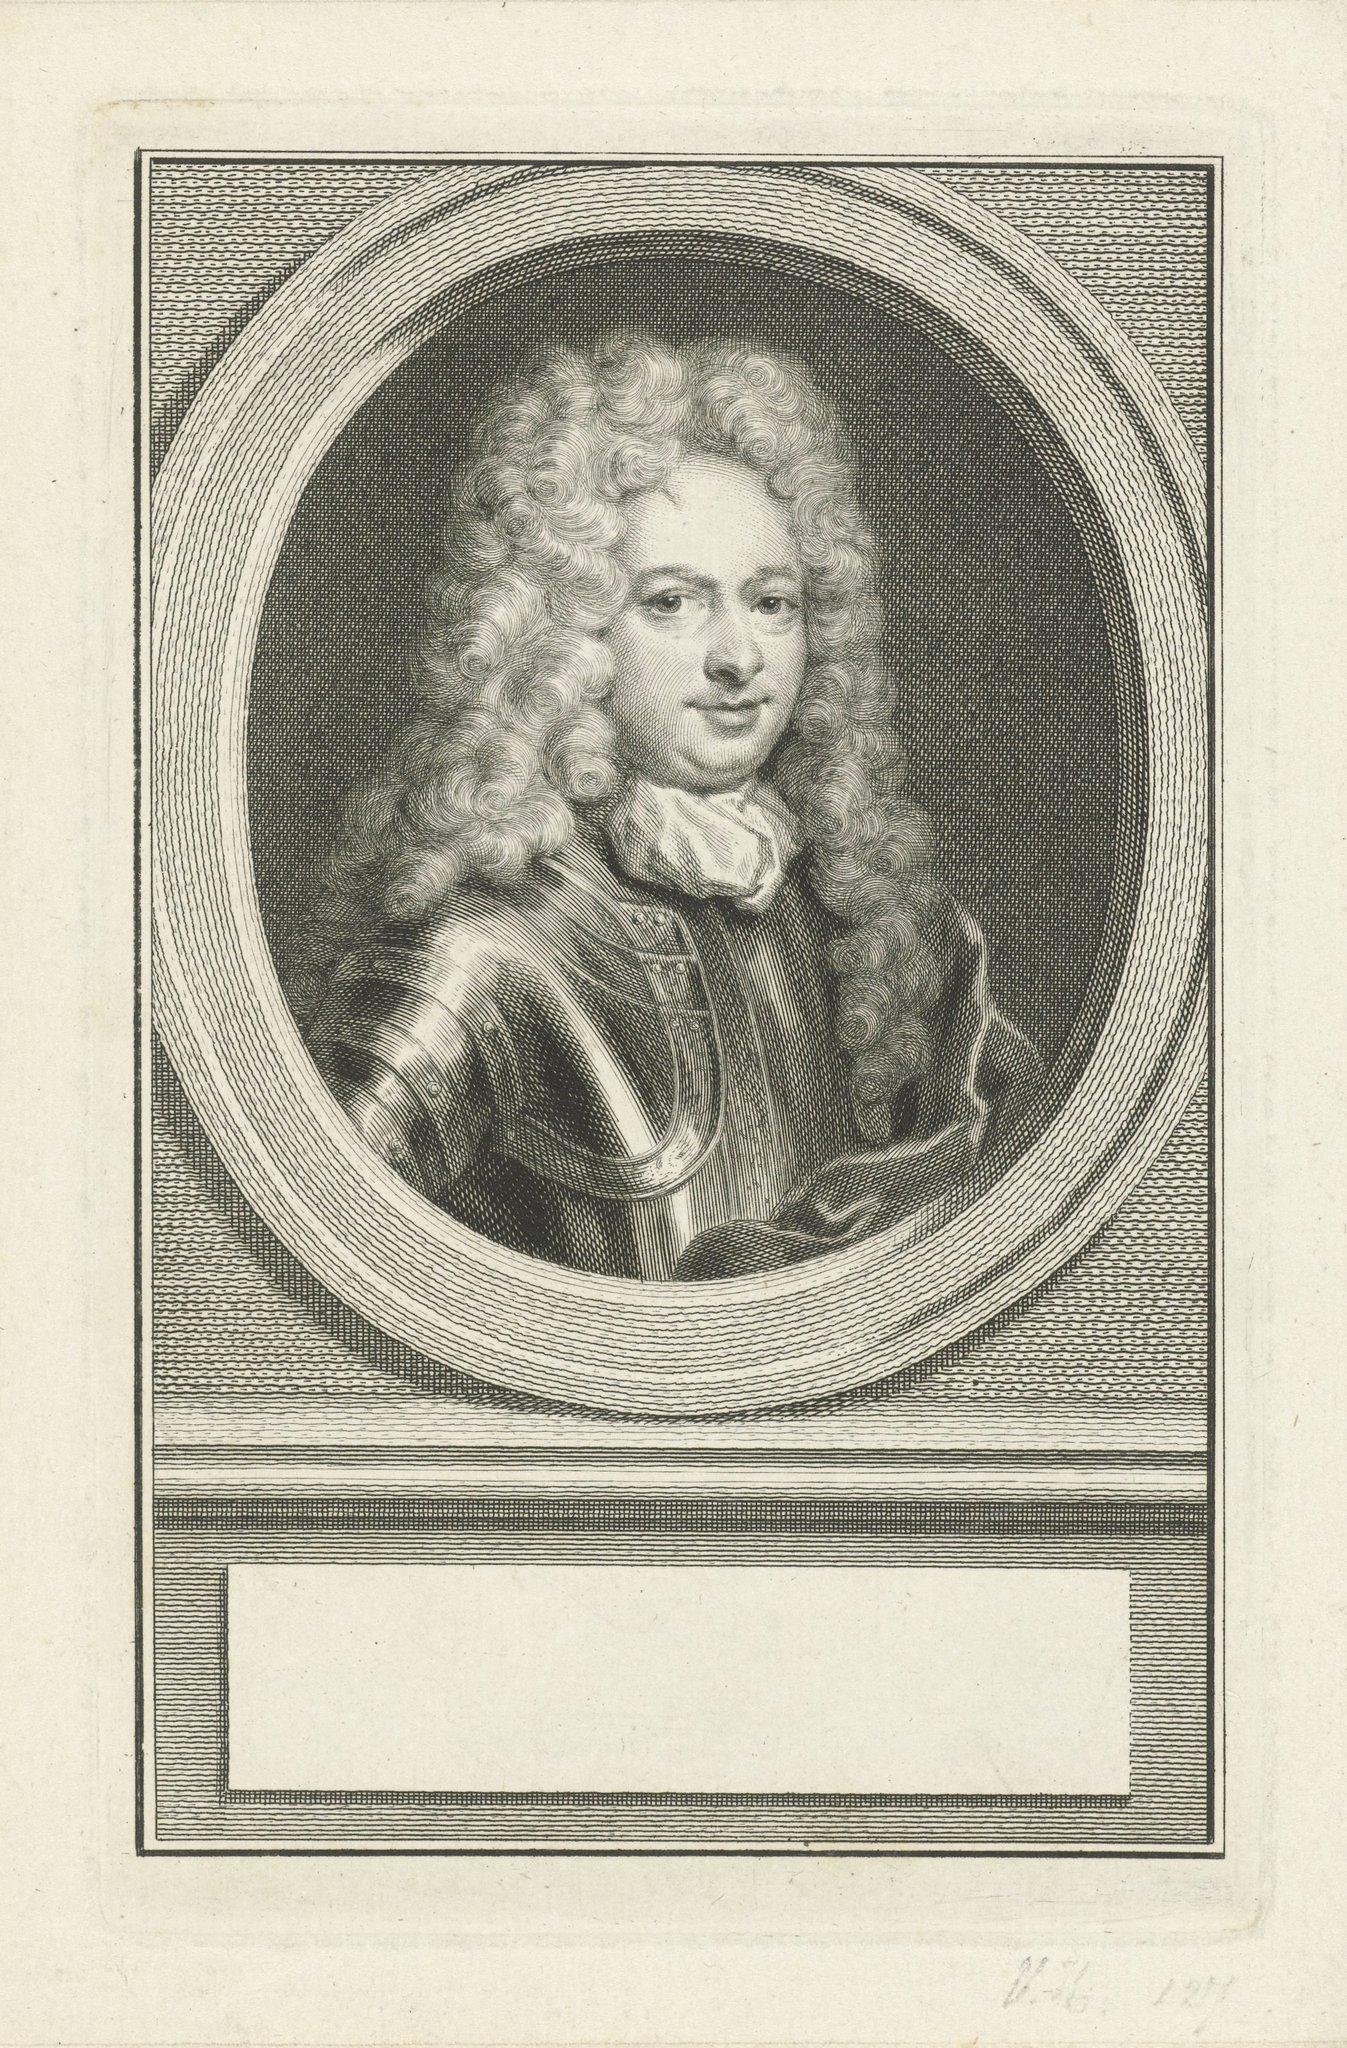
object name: print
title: Portret van François Nicolaas Fagel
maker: jacob houbraken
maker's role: draughtsman, print maker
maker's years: 1698-1780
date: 1747-1759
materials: paper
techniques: engraving, etching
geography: amsterdam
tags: françois nicolaas fagel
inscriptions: collector's mark: Lugt 2228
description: Proefdruk van prent gebruikt in: Jan Wagenaar, Vaderlandsche historie, vervattende de geschiedenissen der nu Vereenigde Nederlanden, inzonderheid die van Holland (...), 21 delen. Amsterdam, Isaak Tirion, 1749-59.